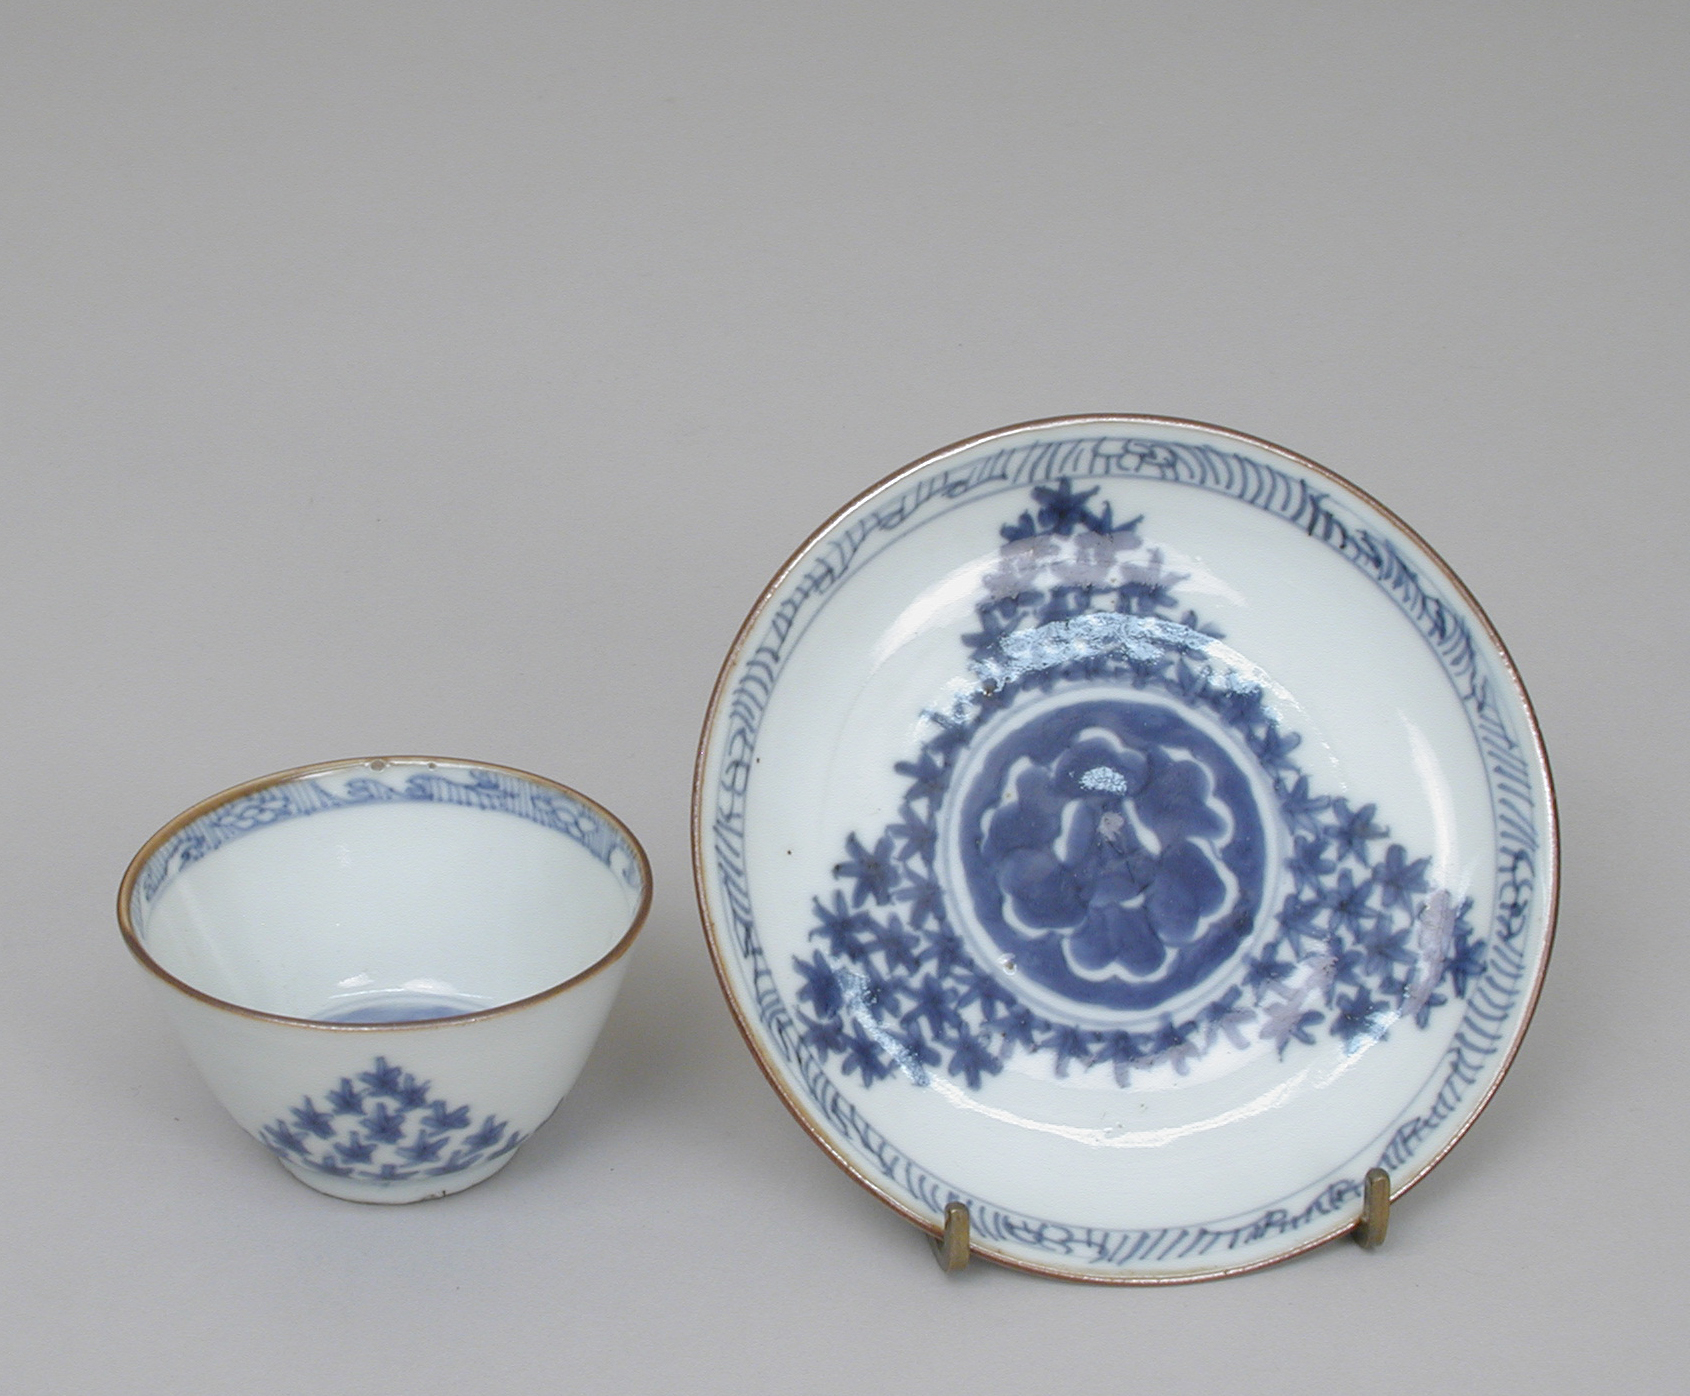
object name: teabowl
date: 1701-1800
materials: hard paste porcelain